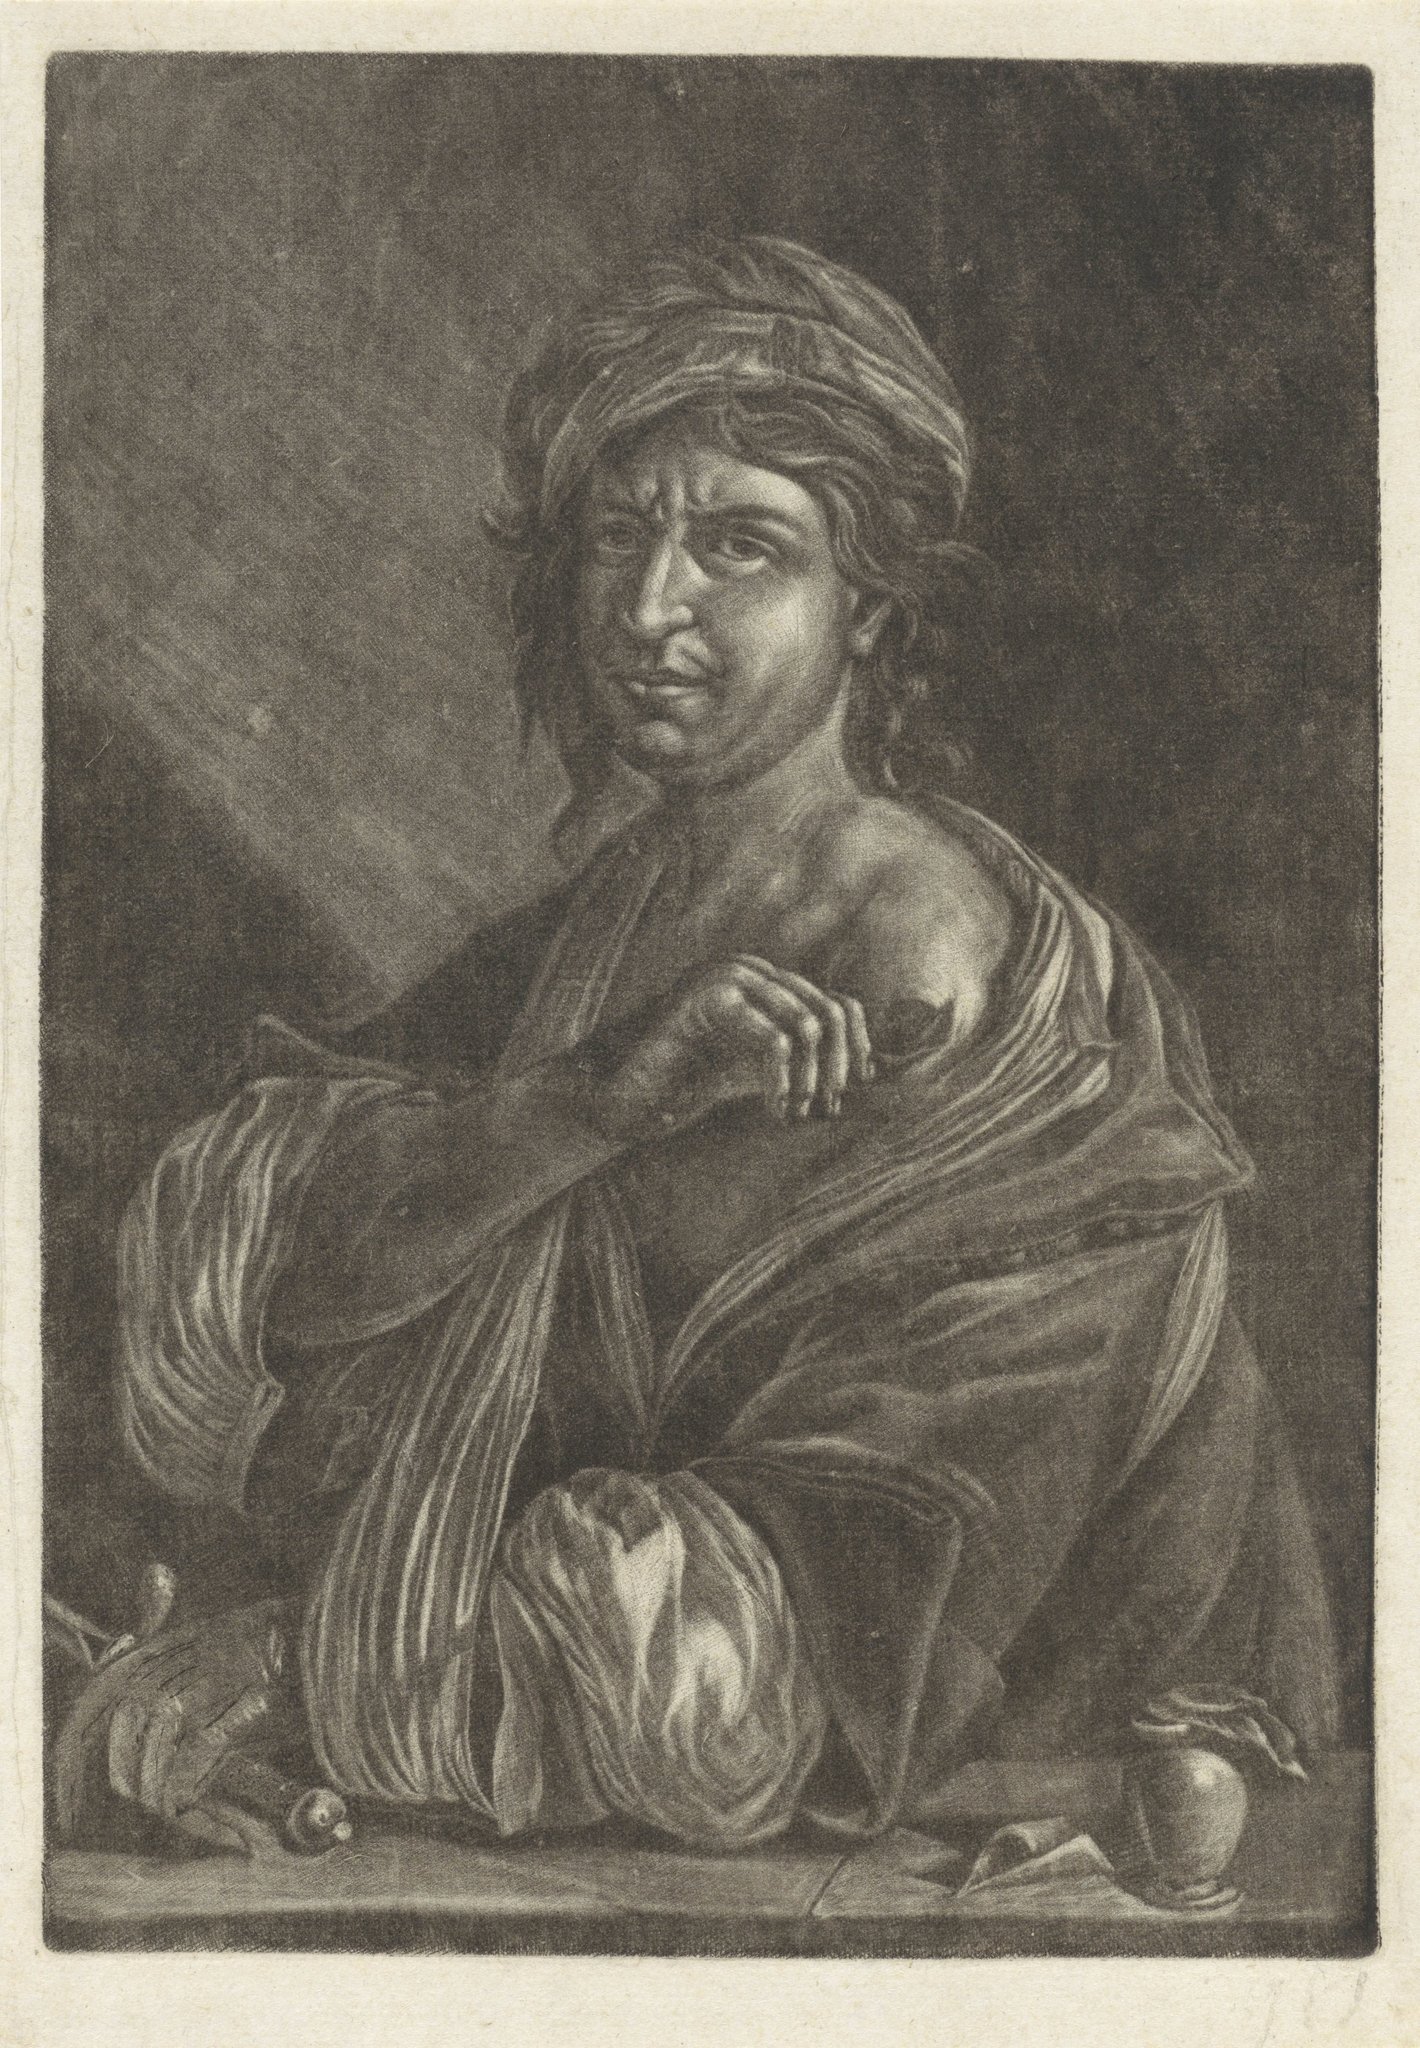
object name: print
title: Gewonde man met een zwaard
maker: jan thomas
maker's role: print maker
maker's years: 1617-1678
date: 1642-1678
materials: paper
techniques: mezzotint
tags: hacking and thrusting weapons: sword, infections and wounds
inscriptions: collector's mark: Lugt 2228